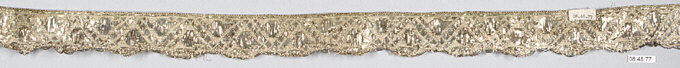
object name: galloon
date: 1701-1800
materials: metal thread